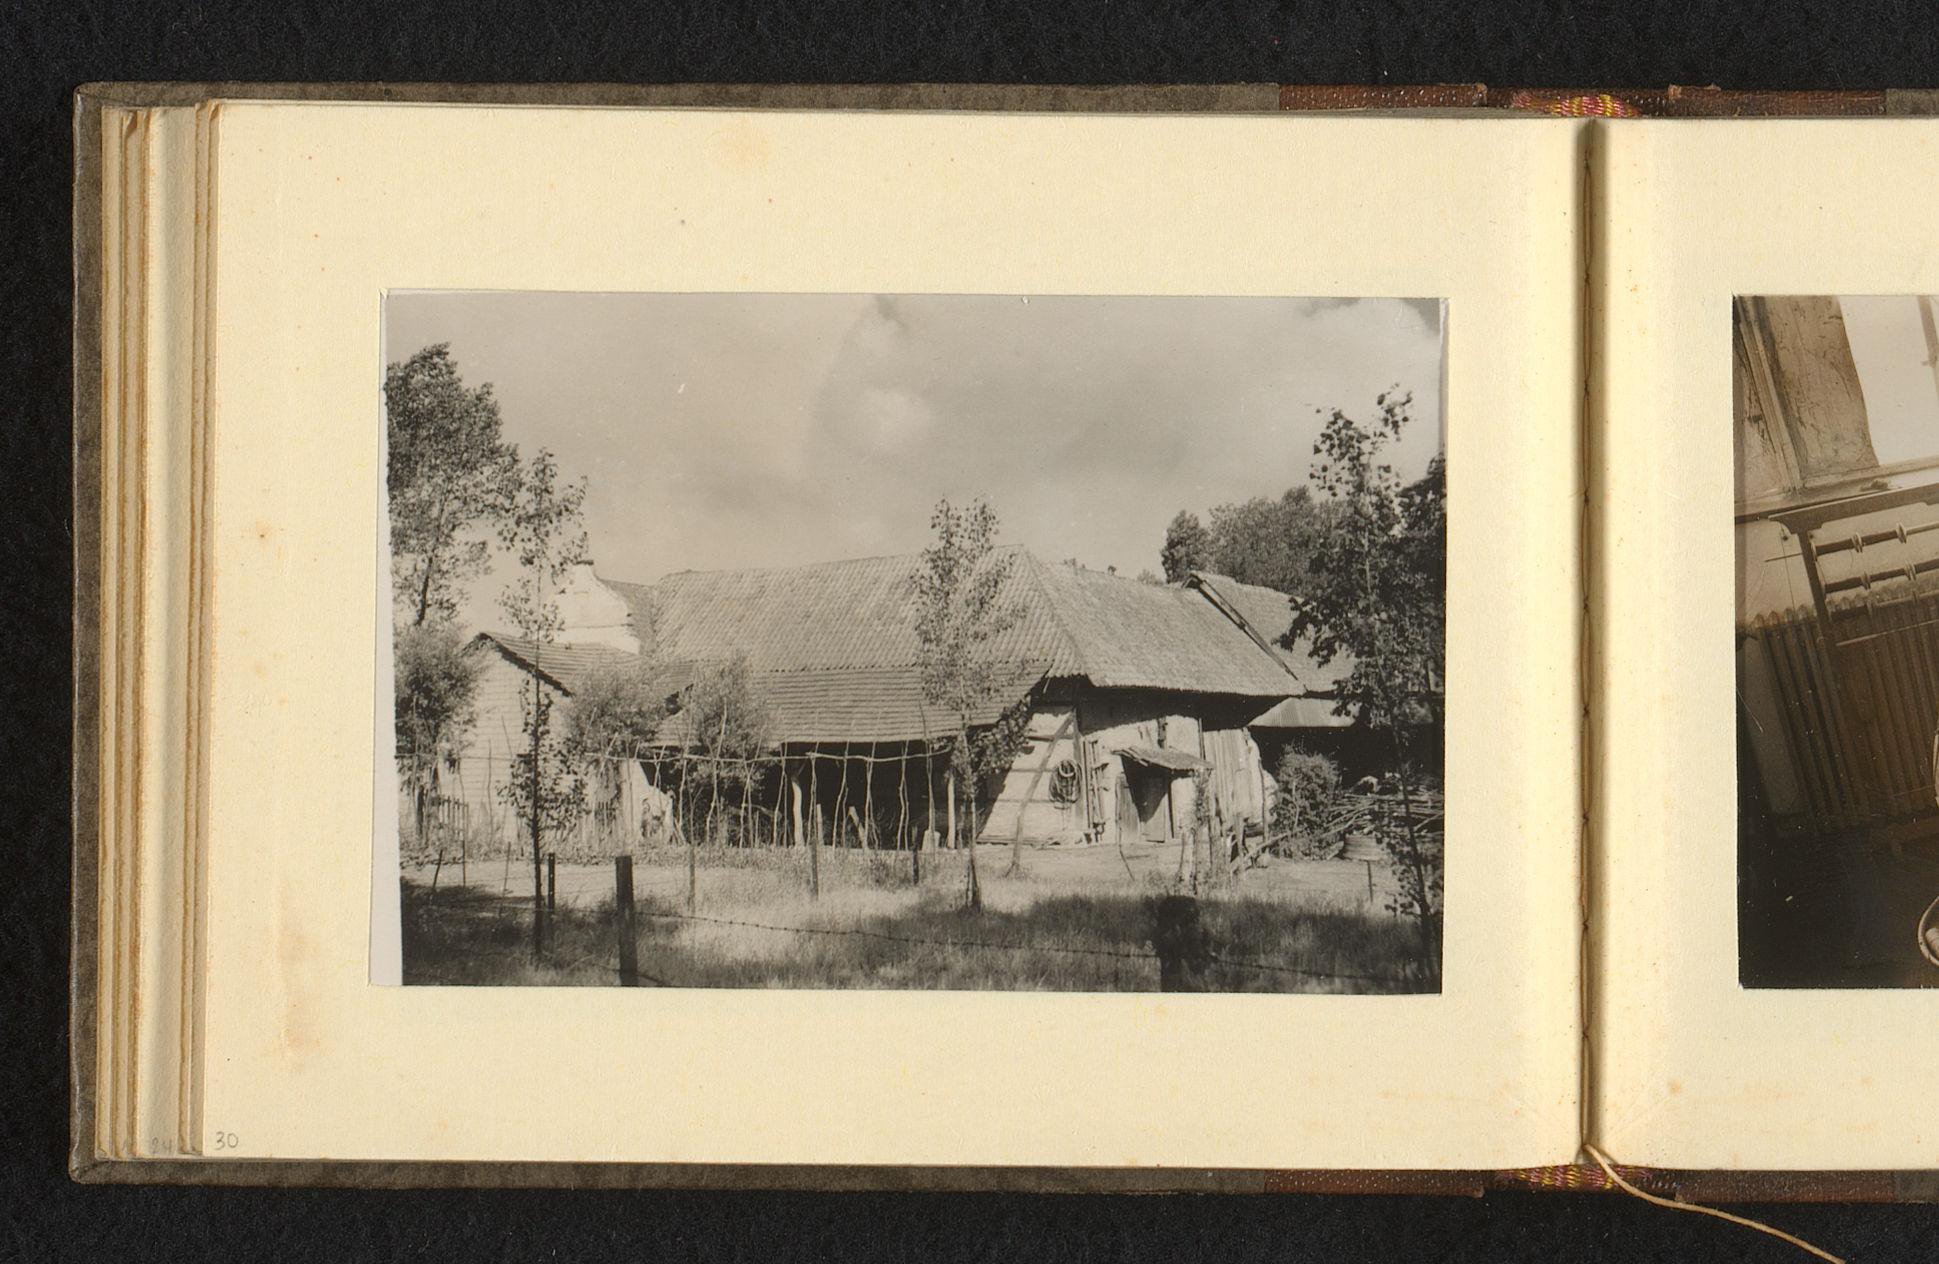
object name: album leaf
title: Gezicht op een boerderij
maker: norbert van den berg (1901-1972)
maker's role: amateurfotograaf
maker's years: 1901-1972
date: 1935-1950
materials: paper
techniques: gelatin silver print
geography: netherlands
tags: farm or solitary house in landscape